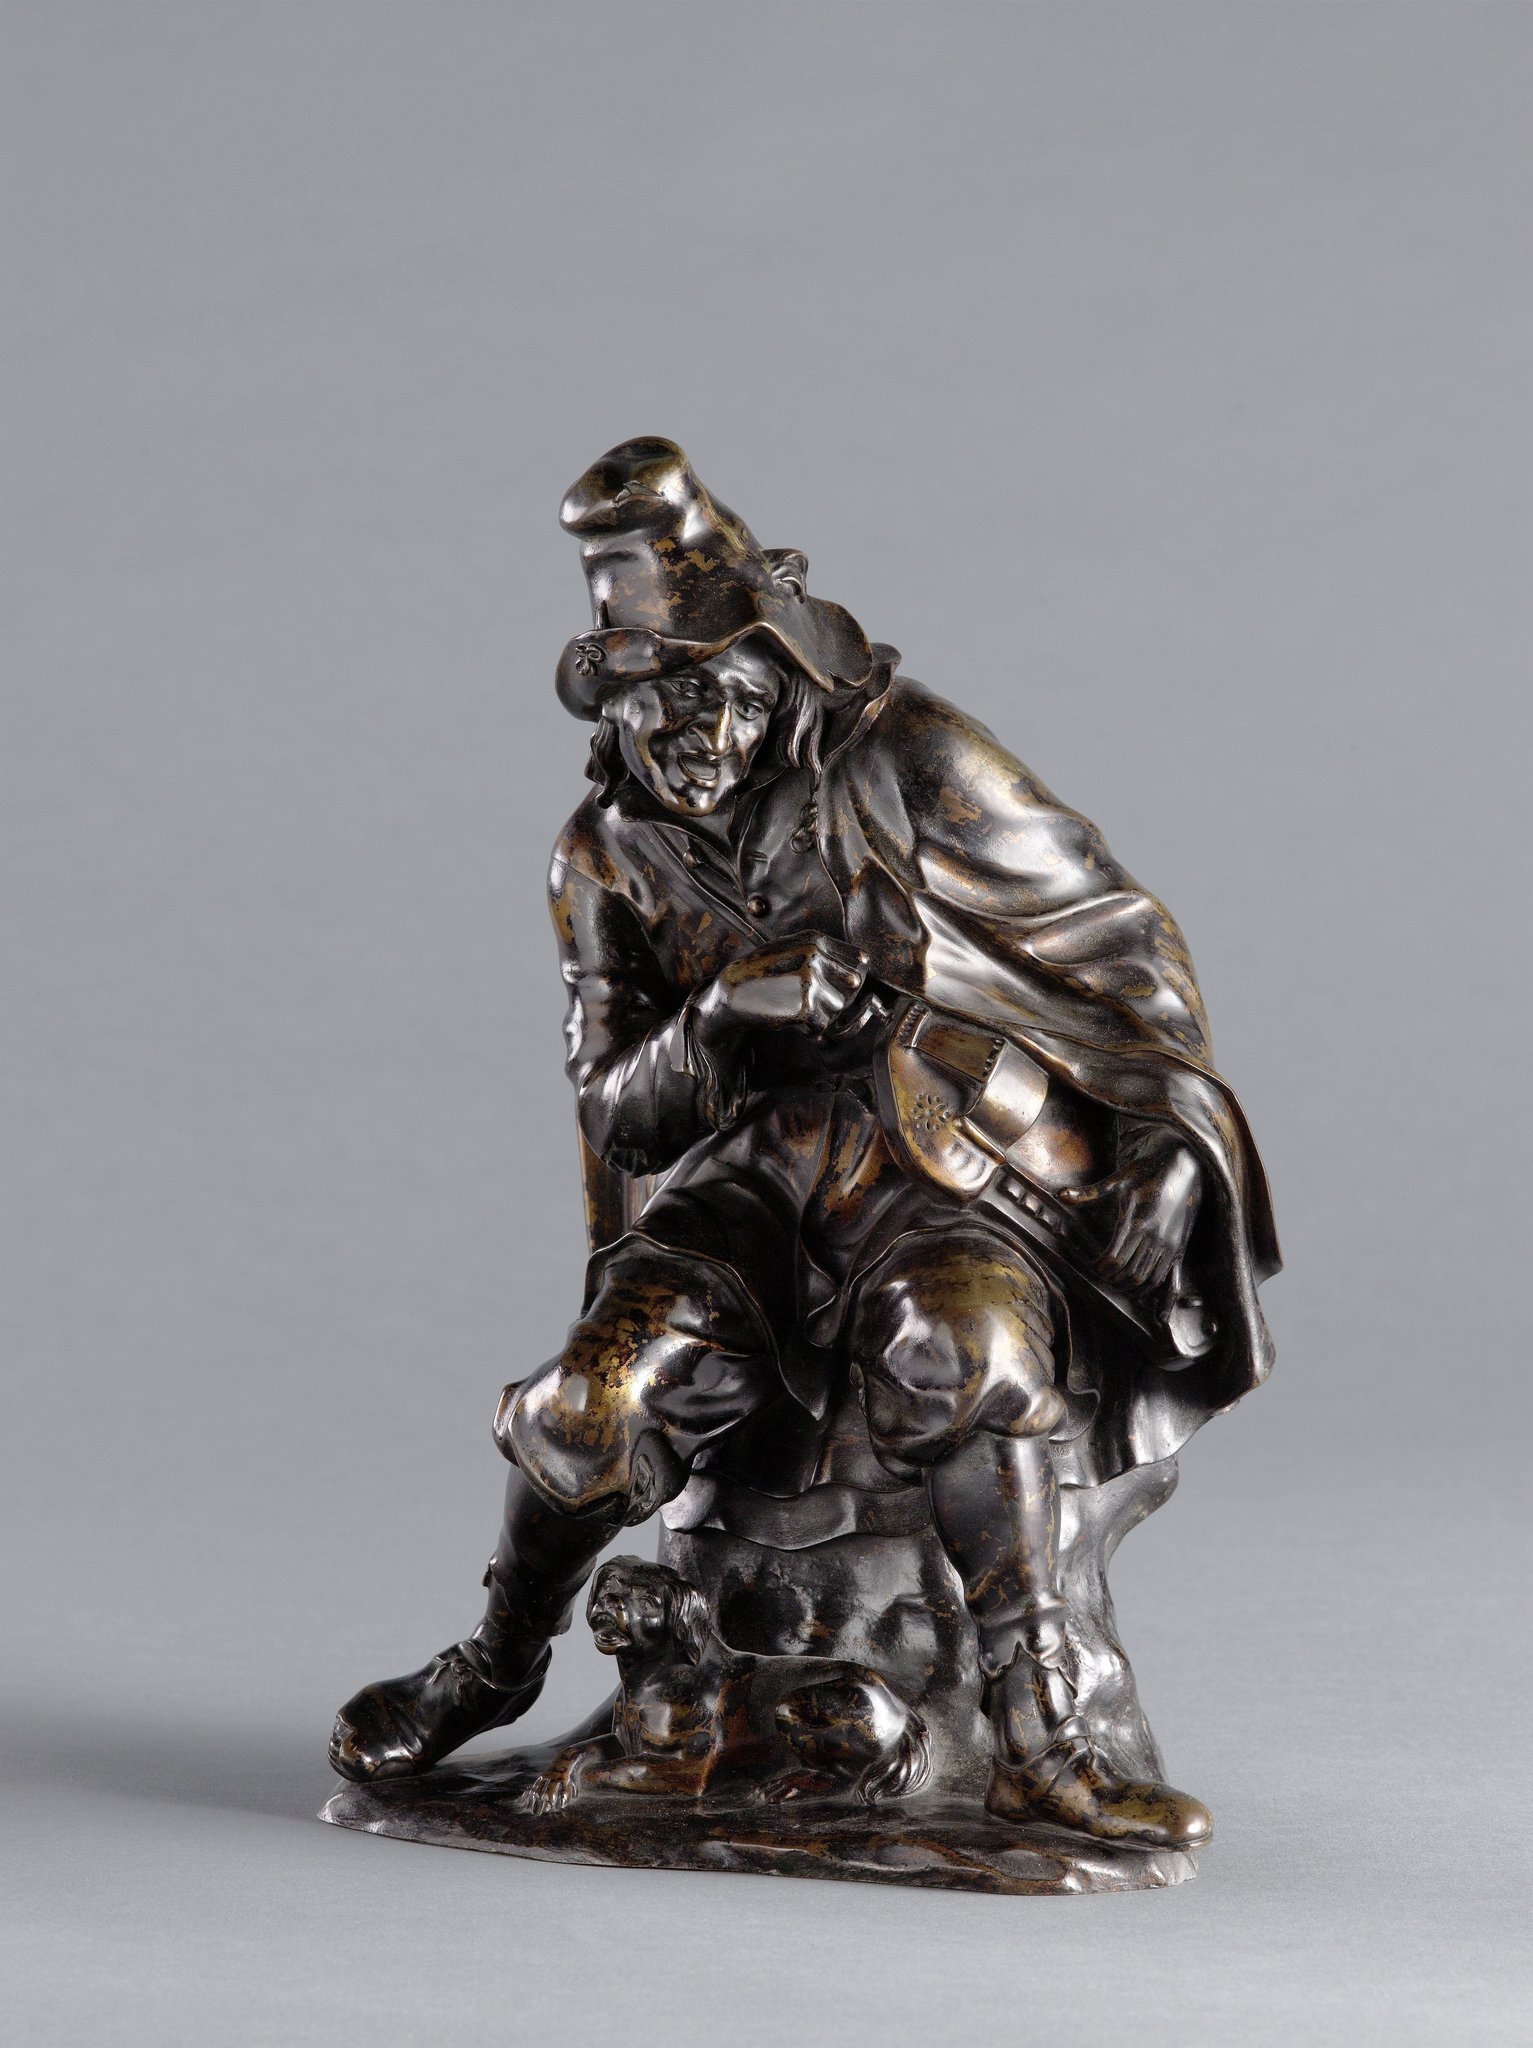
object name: figure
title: Draailierspeler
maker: Anonymous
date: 1700-1725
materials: bronze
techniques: patinaed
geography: southern netherlands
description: De bedelaar is gezeten op een stronk- of rotsachtige basis en laat zijn draailier op zijn linkerdij rusten. Zijn linkerhand bespeelt de toetsen van zijn instrument, terwijl hij met zijn rechterhand het instrument aanzwengelt. De man wendt zich al zingend naar links, terwijl hij naar rechts kijkt. Tussen zijn benen ligt een hond met gekruiste voorpoten. Opvallend zijn verfijnde details als gespen, knopen en de gaten en rafels in zijn kleding. Het beeld bestaat uit twee delen: de figuur zelf en de basis met daarop de hond. De delen zijn aan elkaar bevestigd met behulp van klinknagels, waarvan er één ontbreekt, en een schroef aan de, volledig holle, binnenzijde. Op het brons bevinden zich twee verweerde lakpatina’s. Over een geel-rossige patina is een zwart patina aangebracht. Op de hoed, de schouders, de rug en de knieën is de patina sterk gesleten. Onder de buidel en in de plooien rond de linkerknie en –heup is wat groene oxidatie aanwezig.